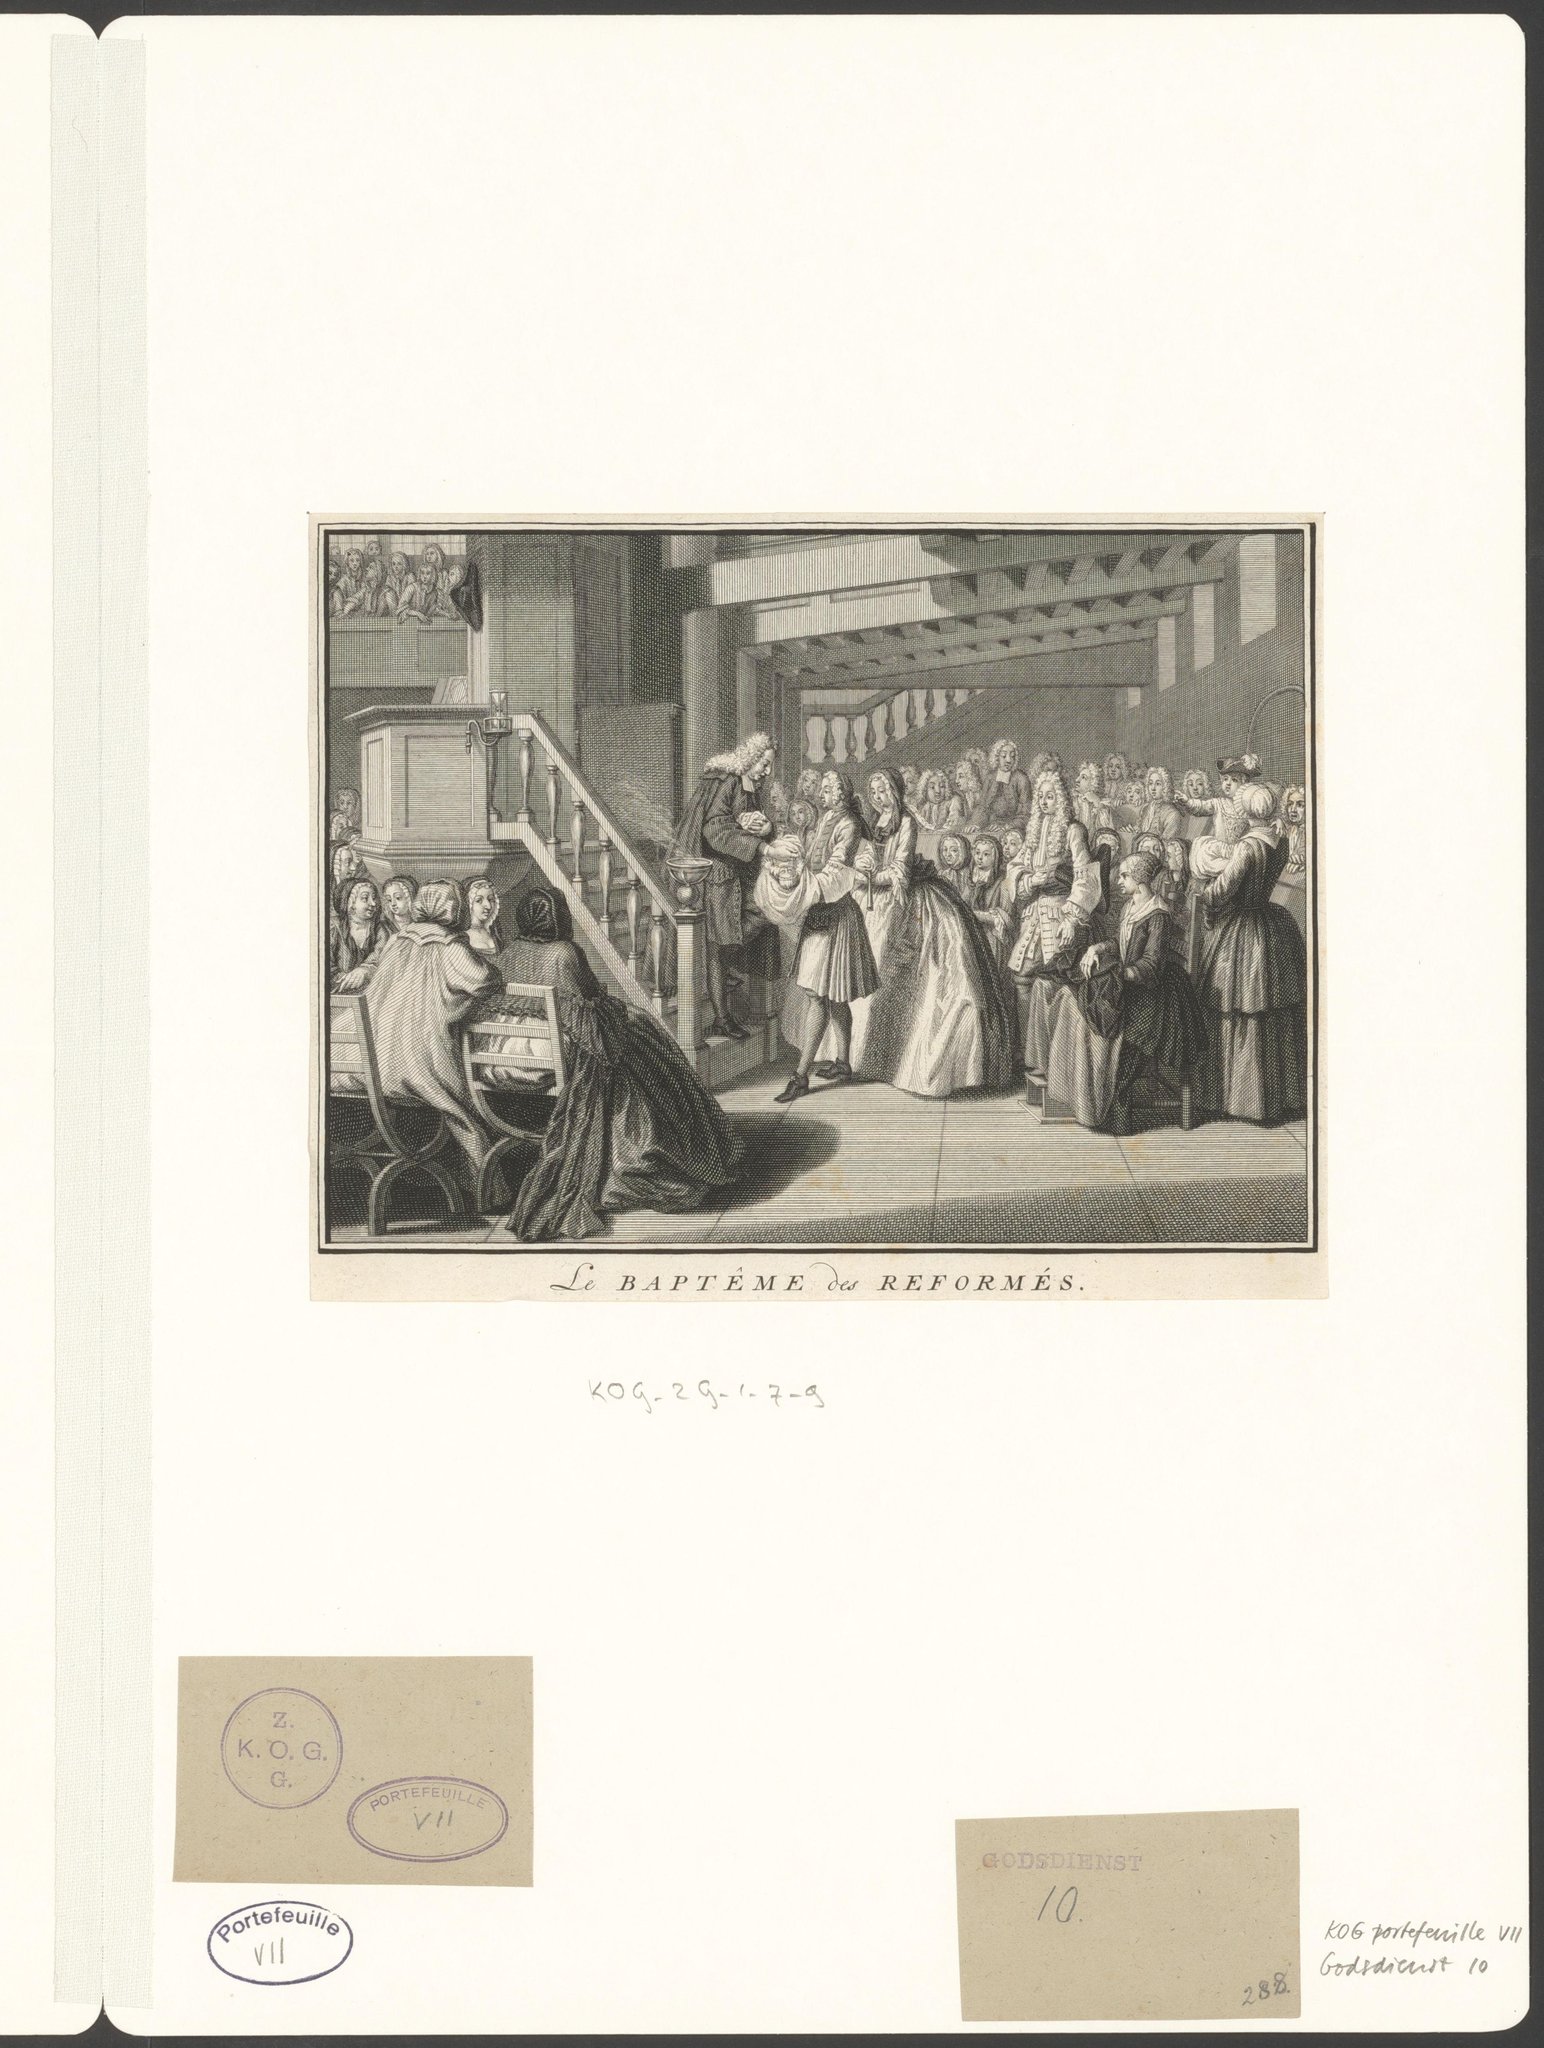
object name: print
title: Avondmaal bij de Gereformeerden te Amsterdam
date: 1731-1733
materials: paper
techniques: engraving, etching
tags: baptism ~ protestant service, amsterdam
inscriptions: collector's mark: Lugt 1641, stamp, stamp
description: Prent gebruikt in en mogelijk gebruikt in andere edities van: Picart, Bernard. Ceremonies et coutumes religieuses de tous les peuples du monde (...). Tome troisieme, qui contient les cérémonies des Grecs & des protestans. Amsterdam: Jean Frederic Bernard, 1733, dl. 3, na p. 394.